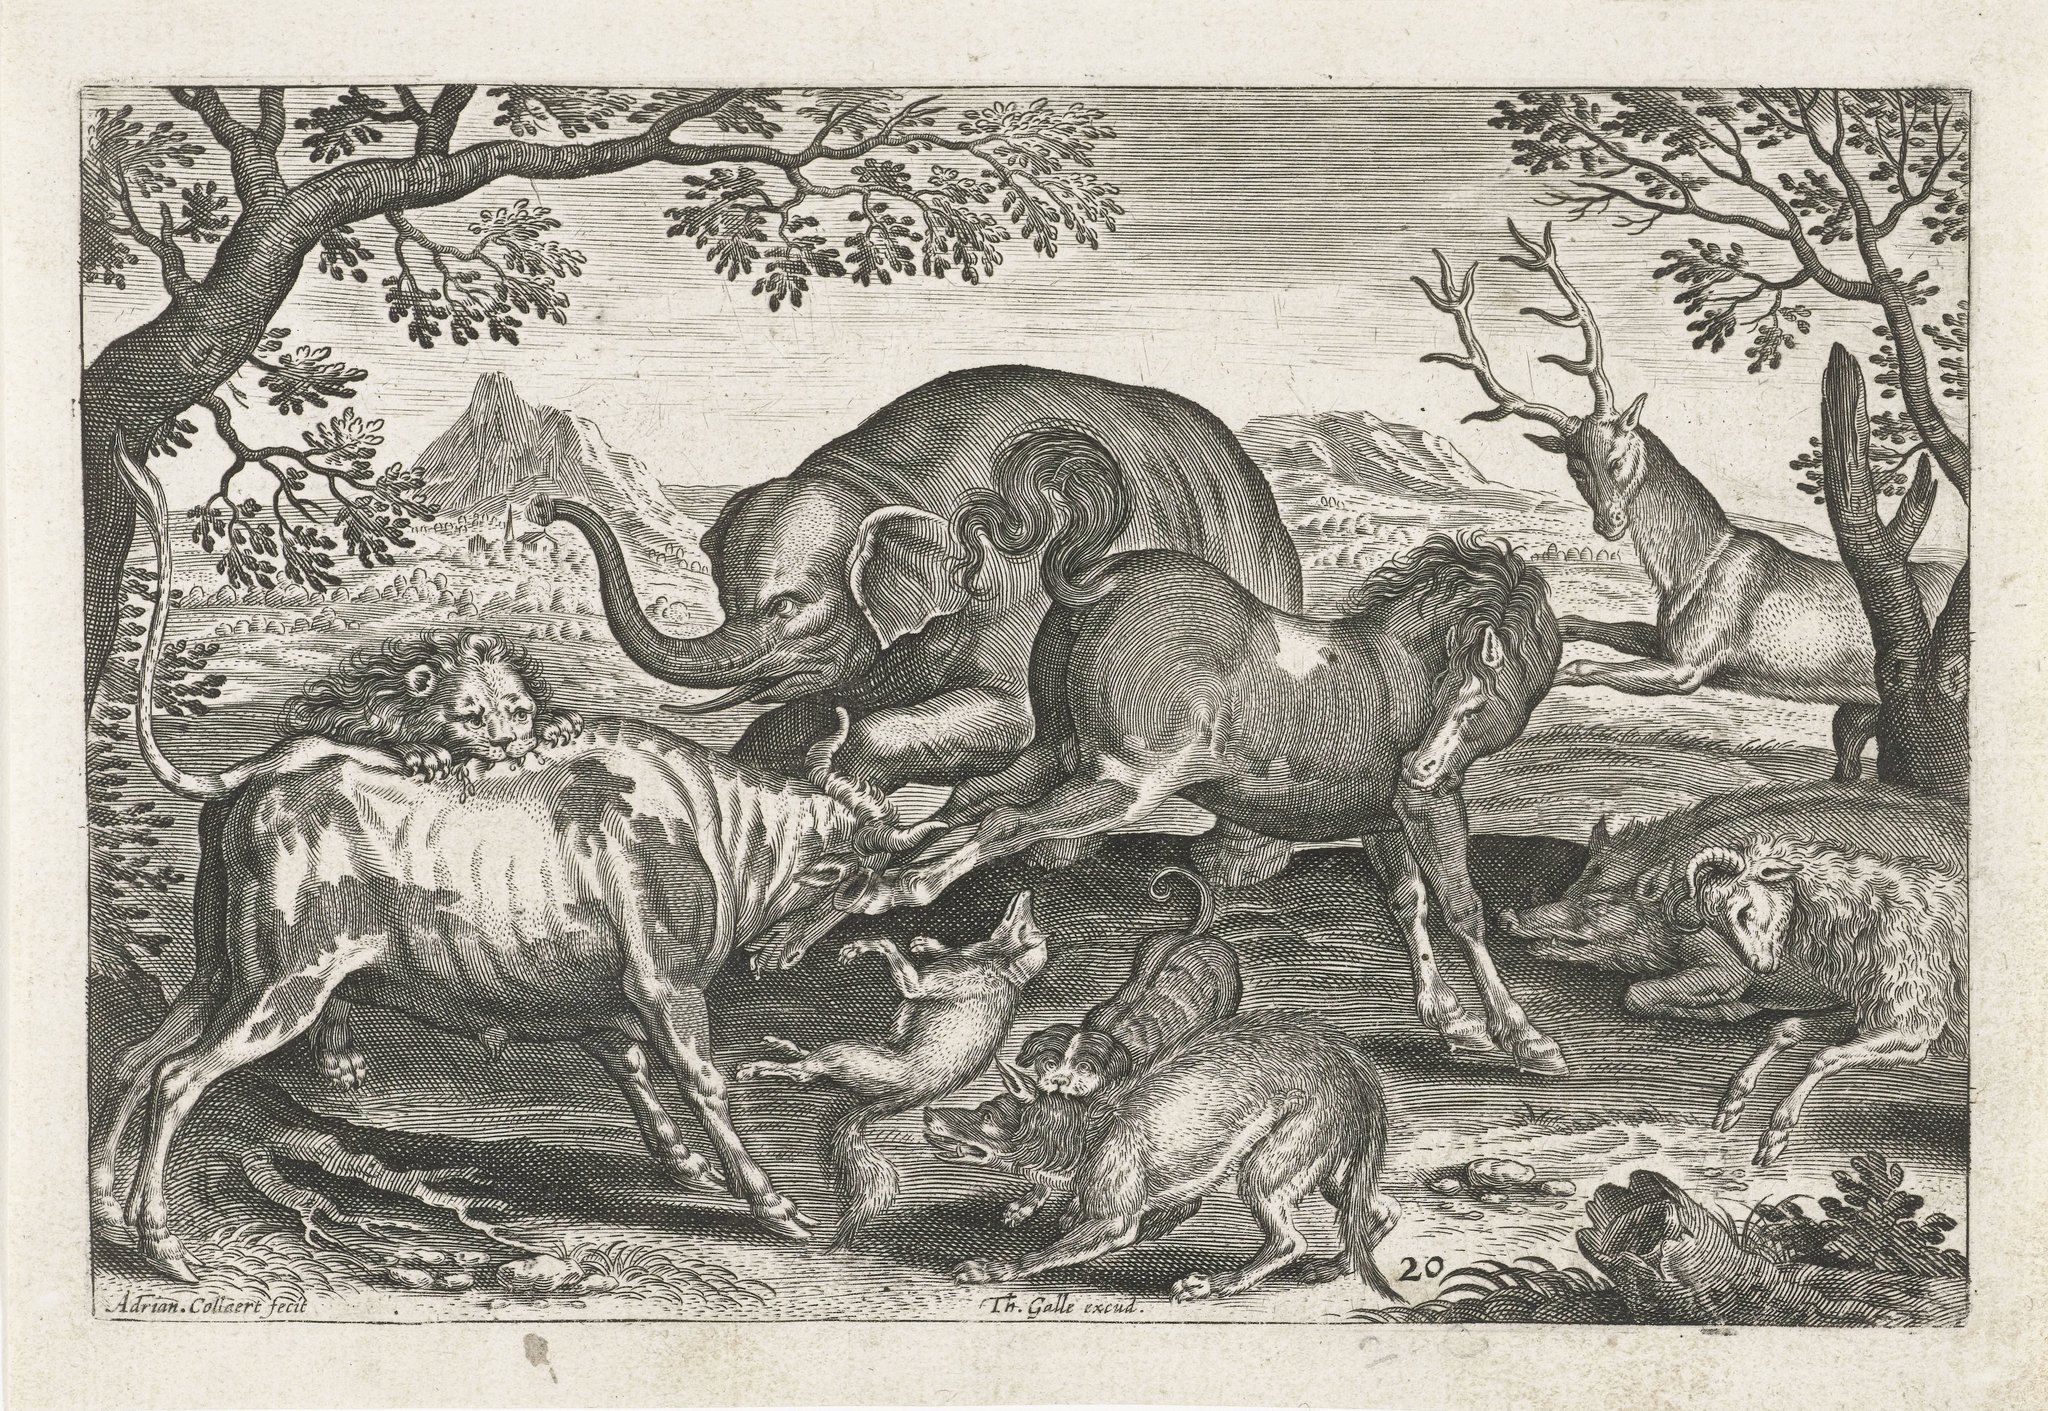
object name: print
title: Vechtende dieren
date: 1595-1599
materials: paper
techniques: engraving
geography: antwerp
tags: bull, hoofed animals: deer, hoofed animals: boar, horse, goat, beasts of prey, predatory animals: lion, trunked animals: elephant, dog, beasts of prey, predatory animals: fox, beasts of prey, predatory animals: wolf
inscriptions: collector's mark: Lugt 2228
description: Een leeuw, een stier, een vos, een wolf, een hond een everzwijn, een geit een paard, een olifant en een hert zijn in gevecht met elkaar. De prent maakt deel uit van een serie met dieren als onderwerp.